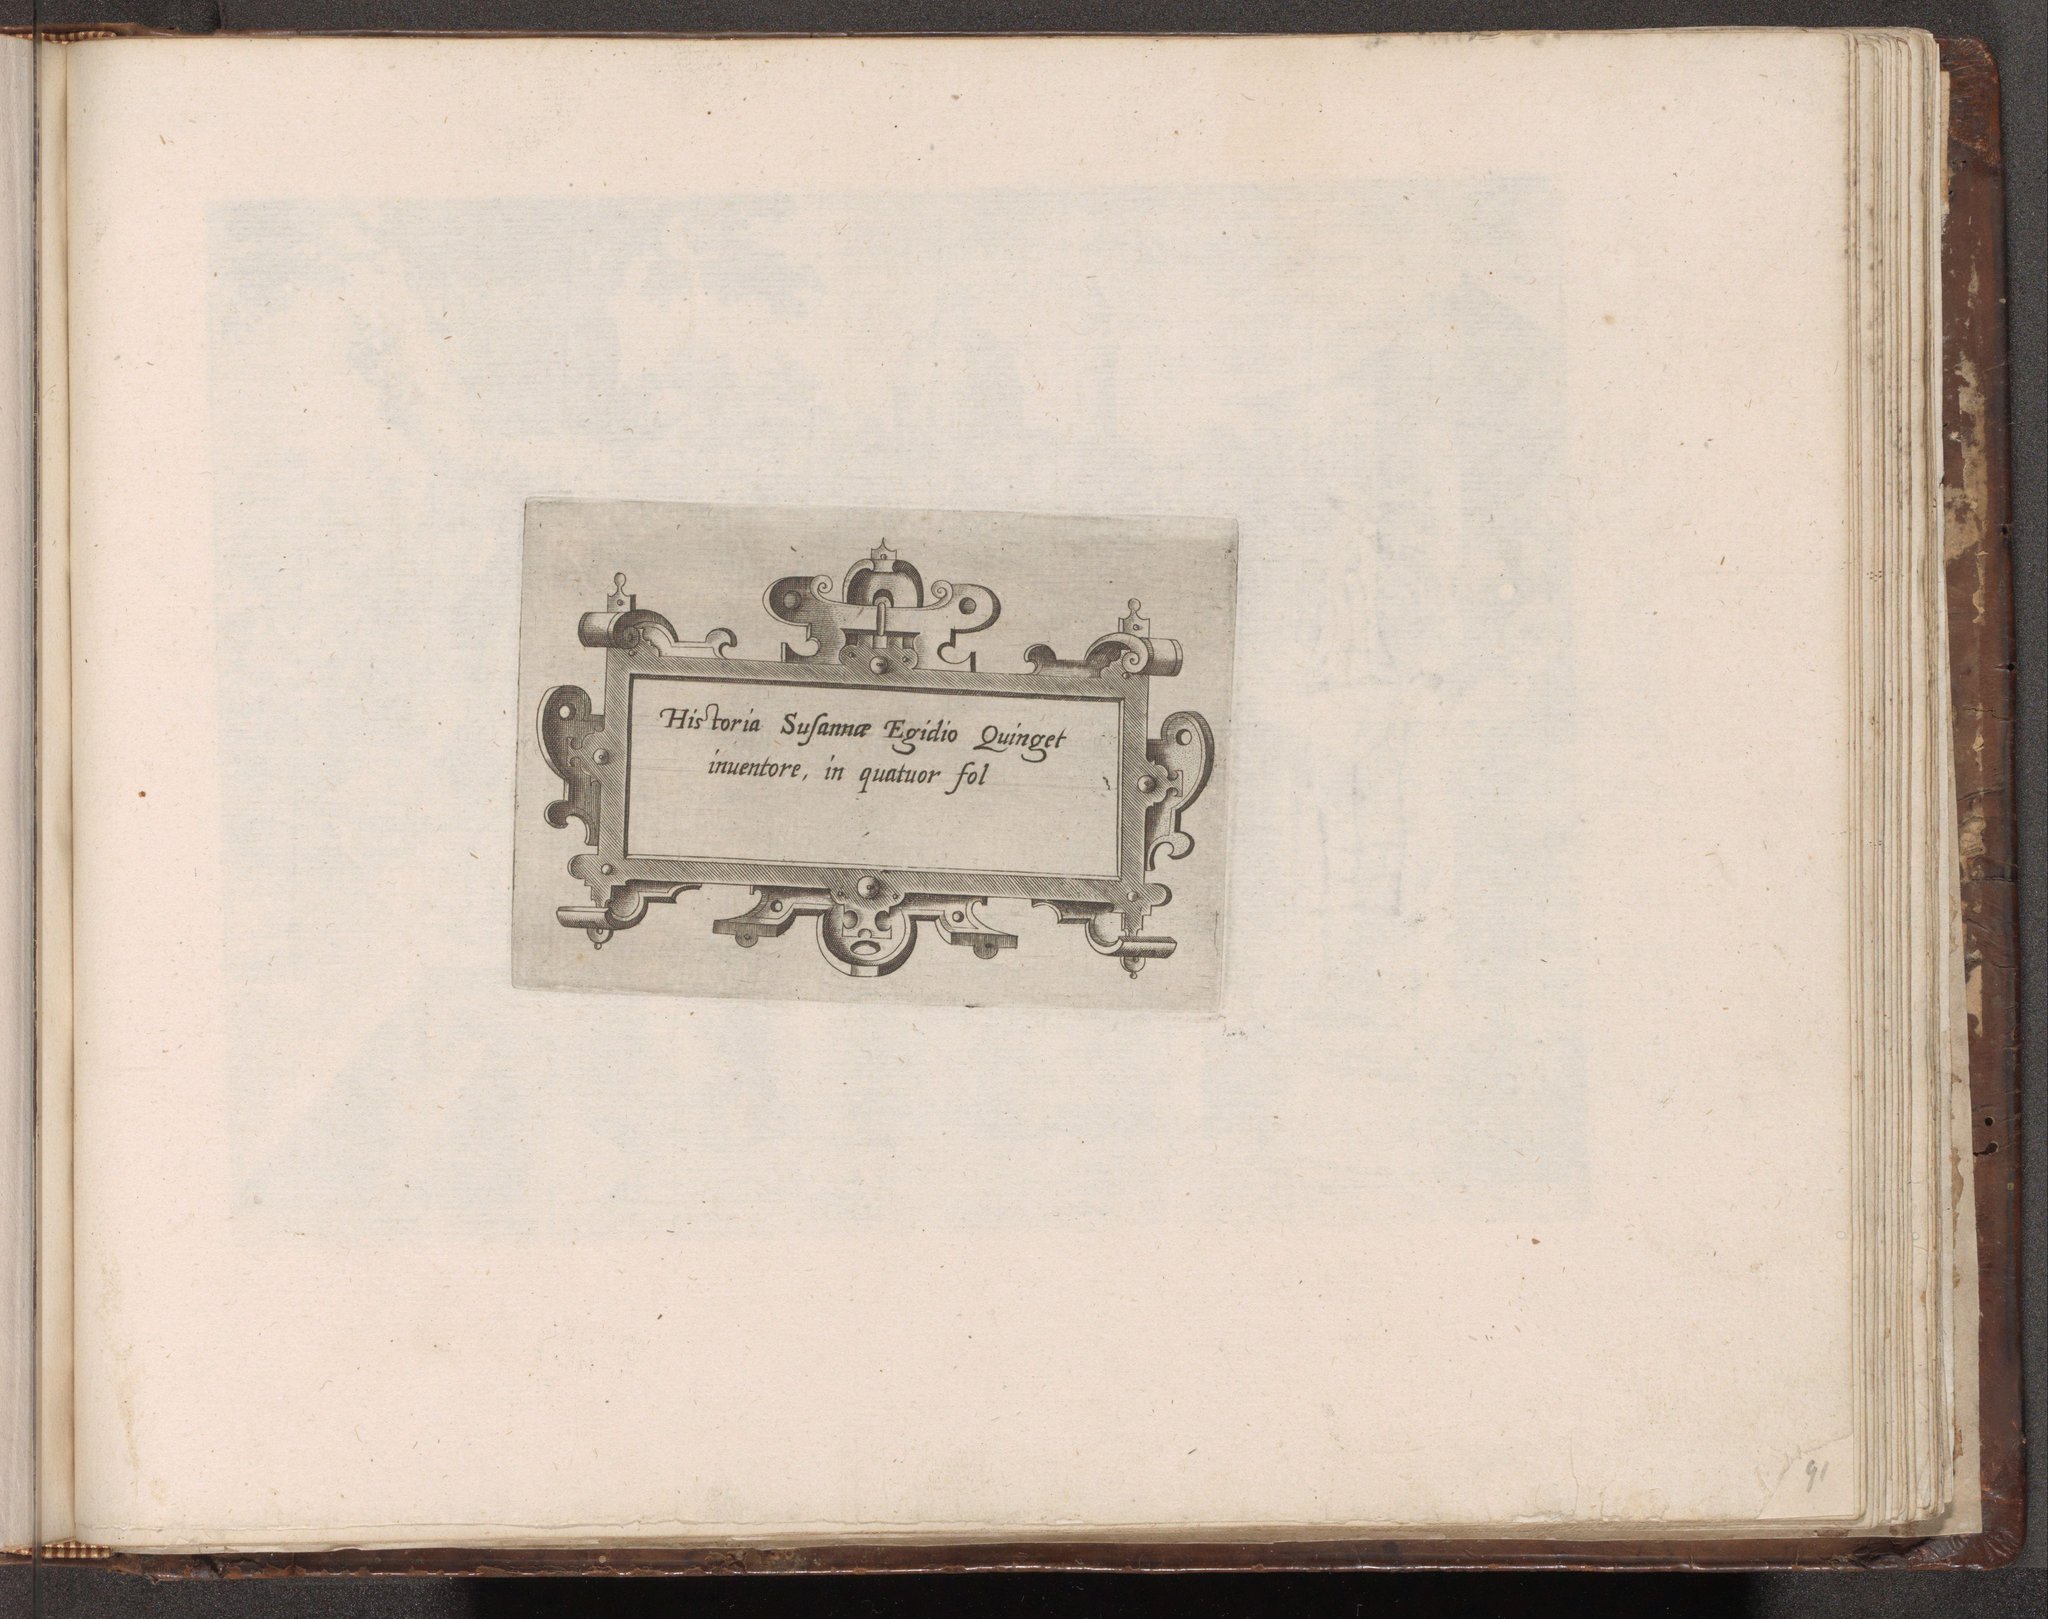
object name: titelprent, frontispice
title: Cartouche met rolwerk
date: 1579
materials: paper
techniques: engraving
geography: antwerp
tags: scrollwork, strapwork ~ ornament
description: Titel in cartouche met rolwerk. Titelprent voor een serie prenten over de geschiedenis van Susanna. Prent maakt deel uit van een album.